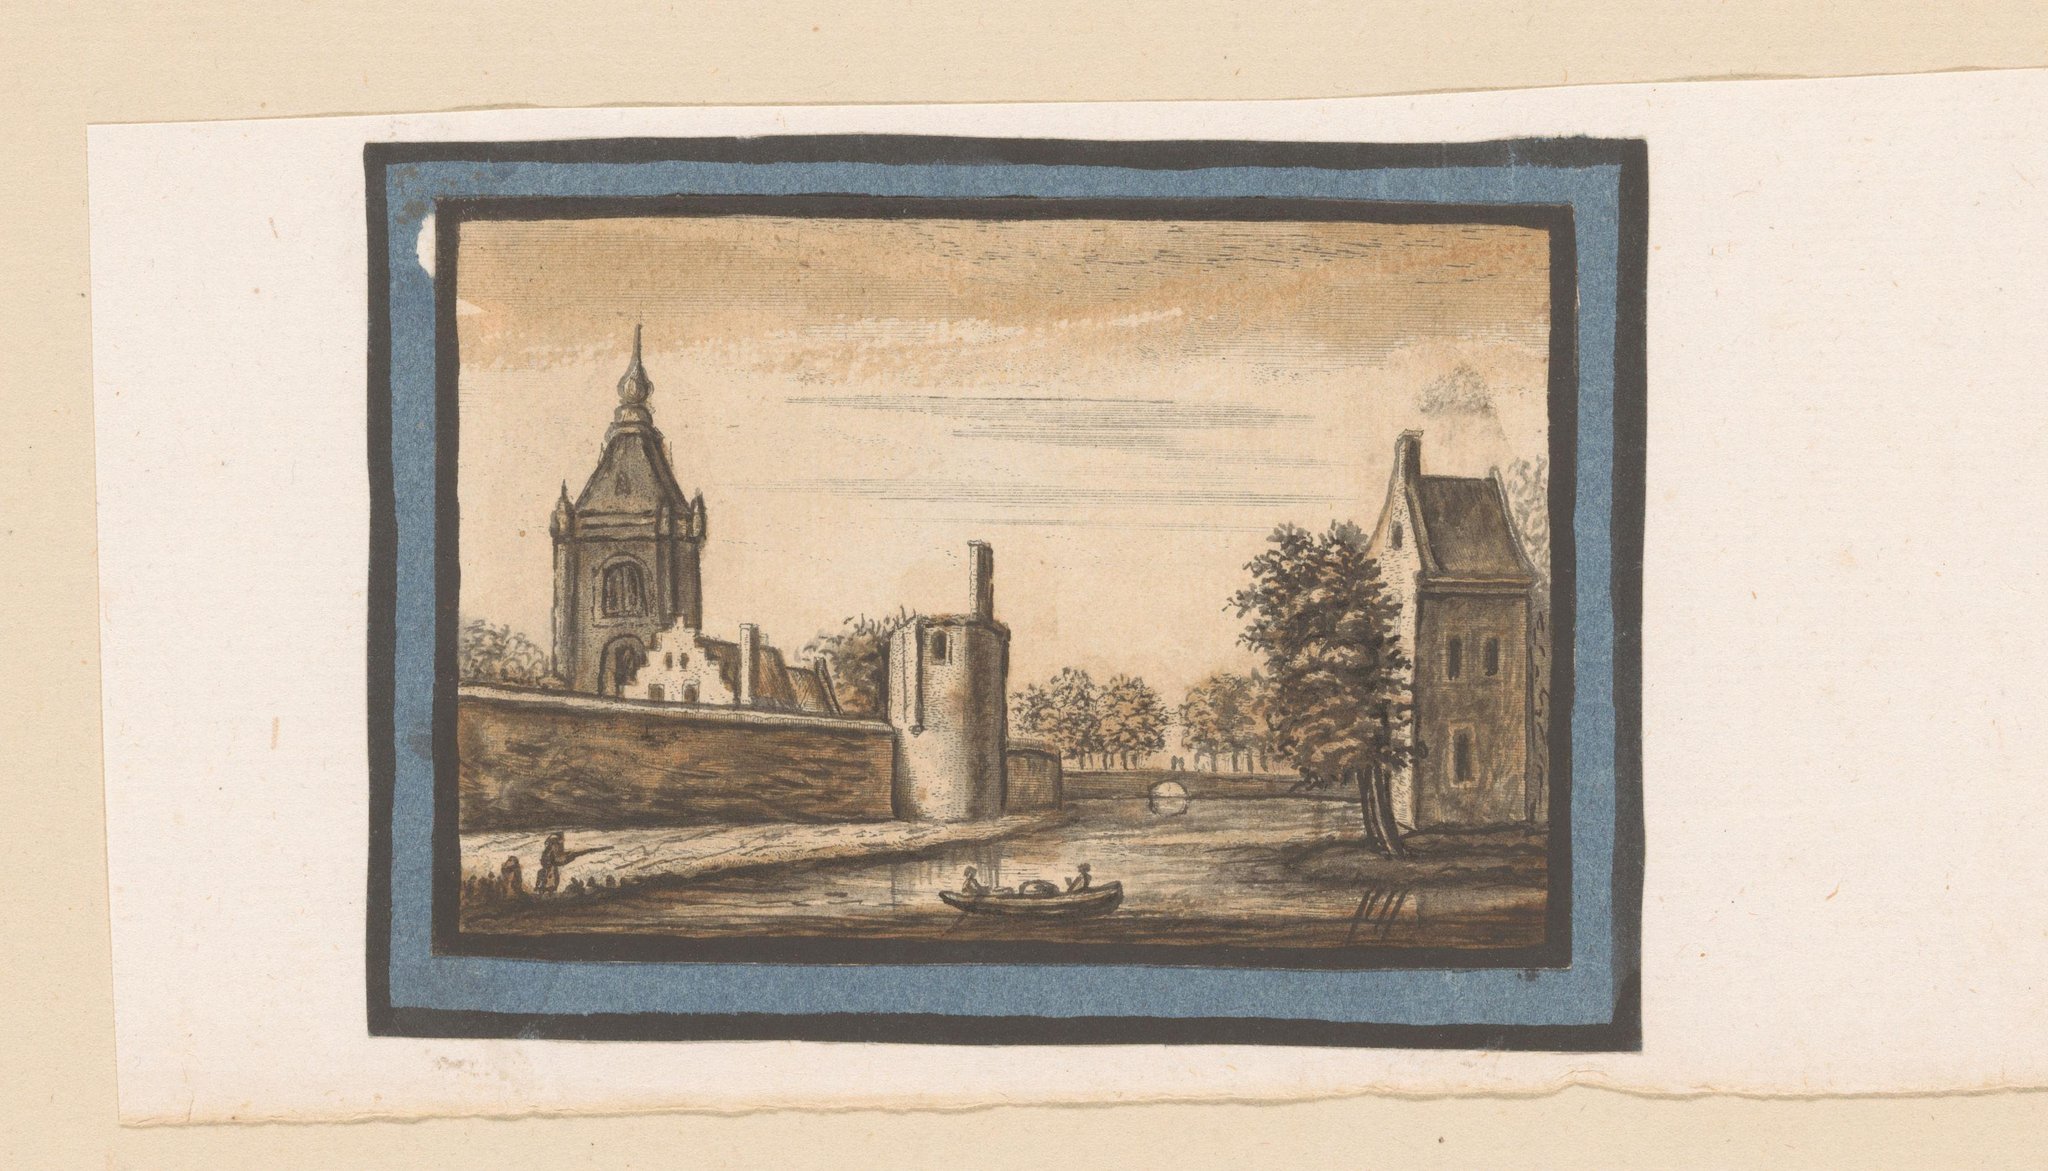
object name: drawing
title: Gezicht op het kasteel van Montfoort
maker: Anonymous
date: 1725-1750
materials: ink, paper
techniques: brush, pen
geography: amsterdam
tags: castle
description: Naar prent uit: Rademaker, Abraham. Kabinet van Nederlandsche outheden en gezichten: vervat in 300 konstplaten. Amsterdam: Willem Barents, 1725.